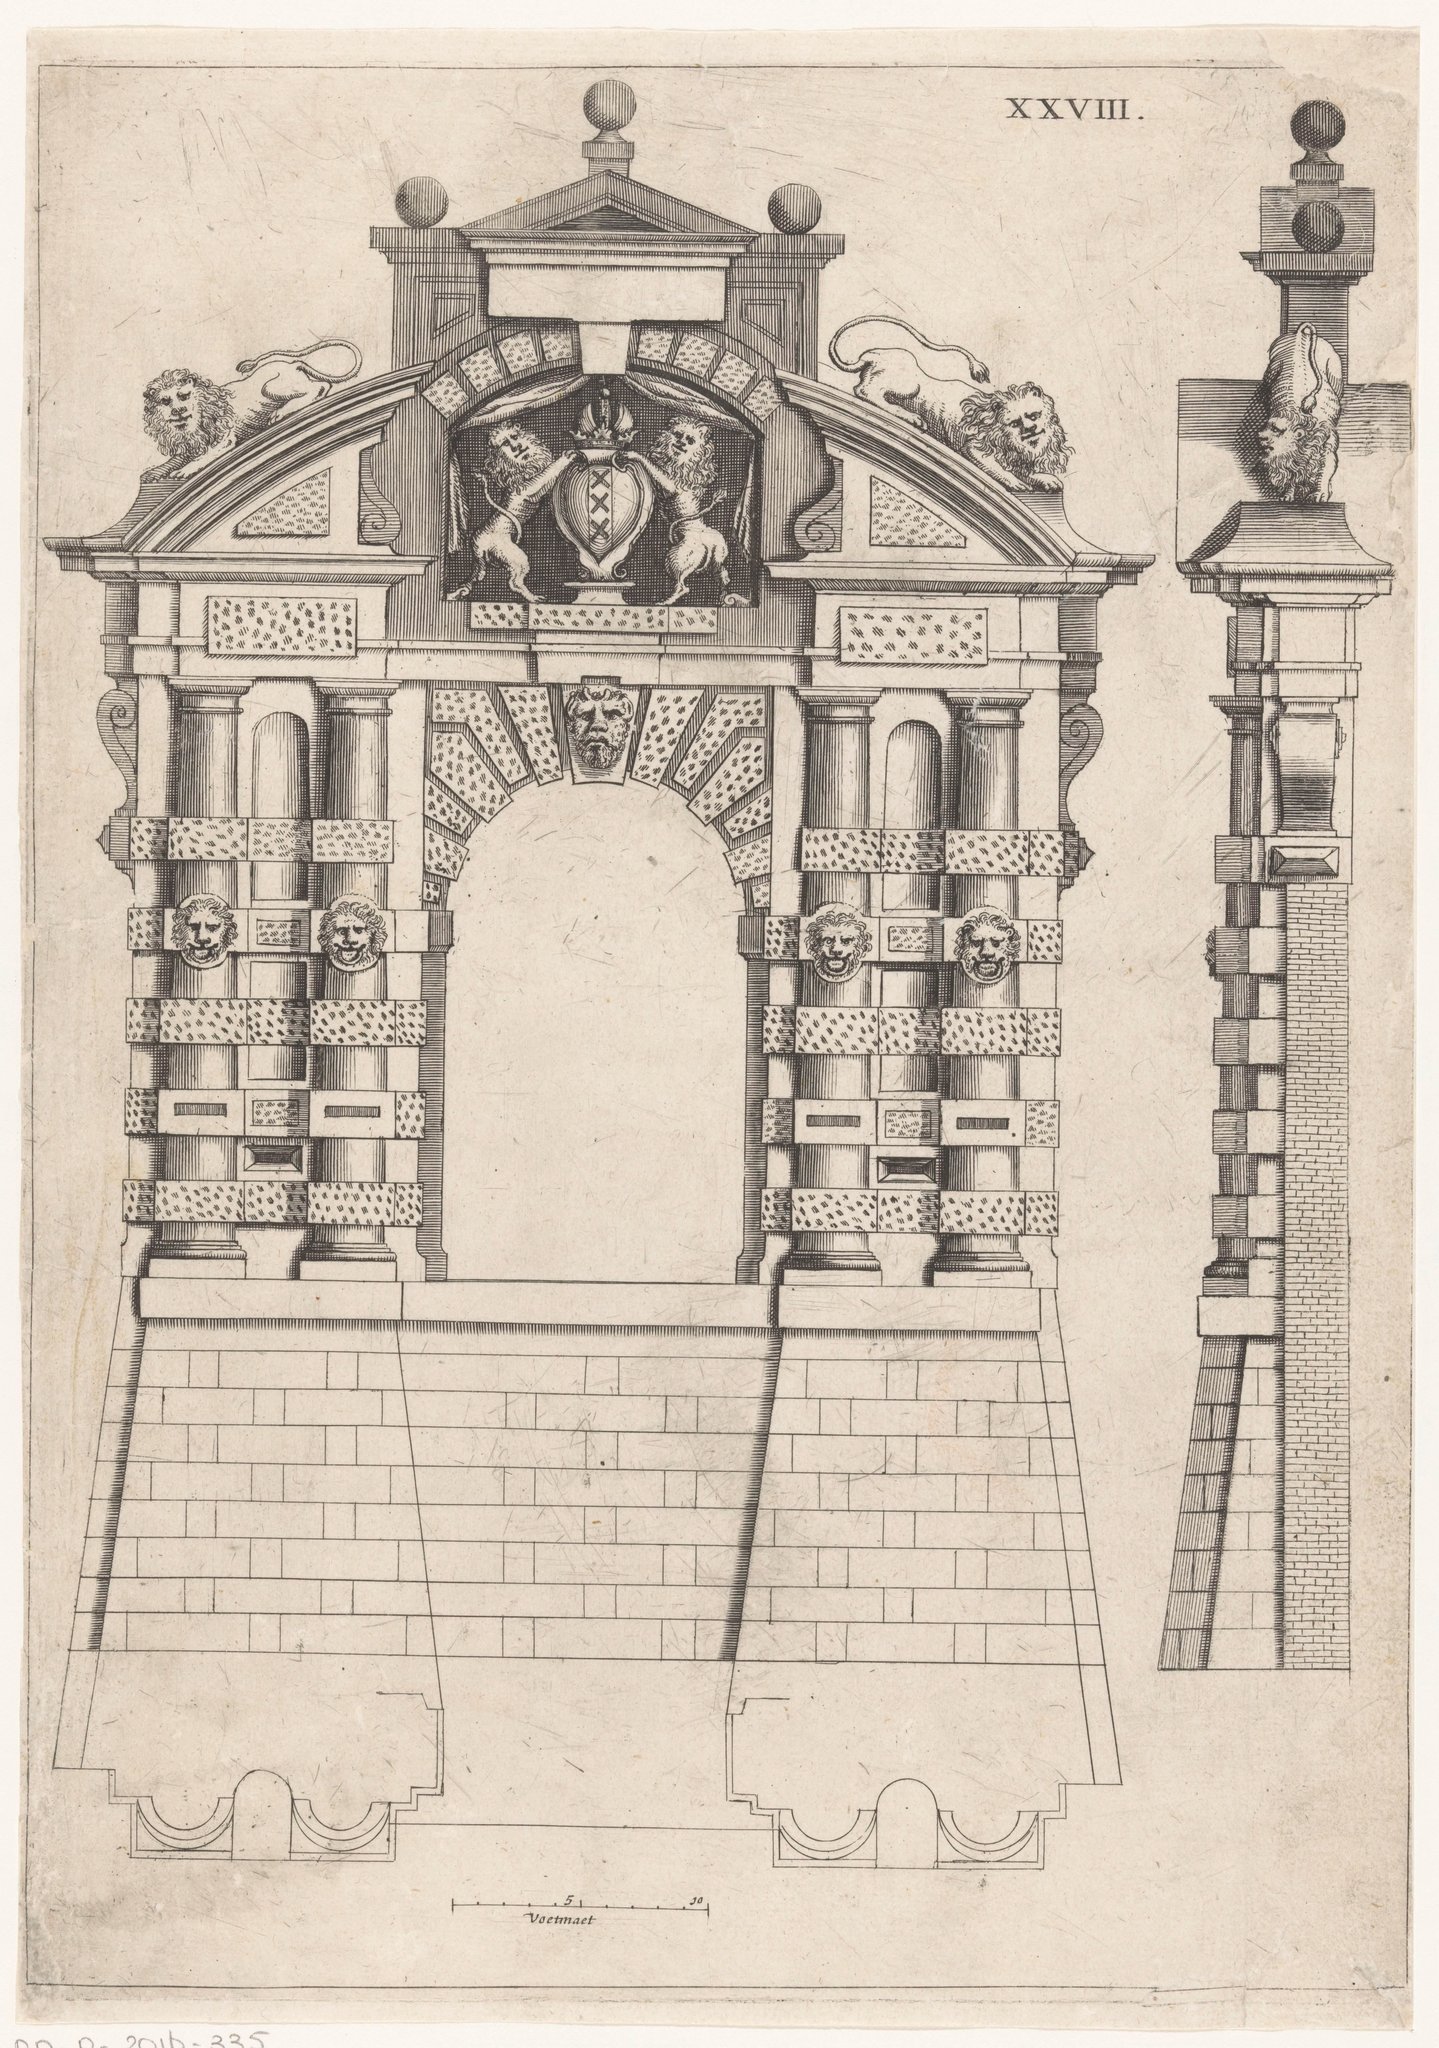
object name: book illustration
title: Architectura moderna ofte Bouwinge van onsen tyt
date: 1631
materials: paper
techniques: engraving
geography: amsterdam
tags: gate ~ fortified city, plan ~ architecture, exterior ~ architectural design or model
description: Prent uit: Keyser, Hendrick de. Architectura moderna ofte bouwinge van onsen tyt (...) alle gedaen by (...) Amsterdam: Danckerts, Cornelis, 1631.